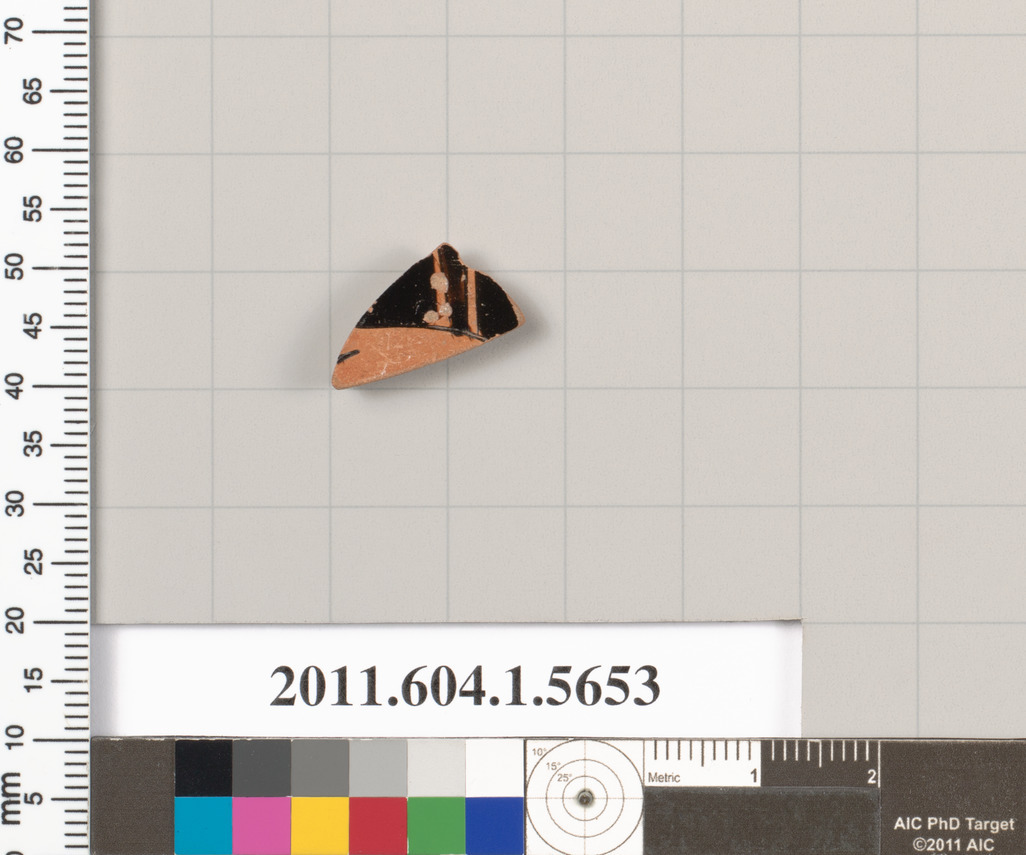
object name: kylix fragment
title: Terracotta fragment of a kylix (drinking cup)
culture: greek, attic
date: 500-480 BCE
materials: terracotta